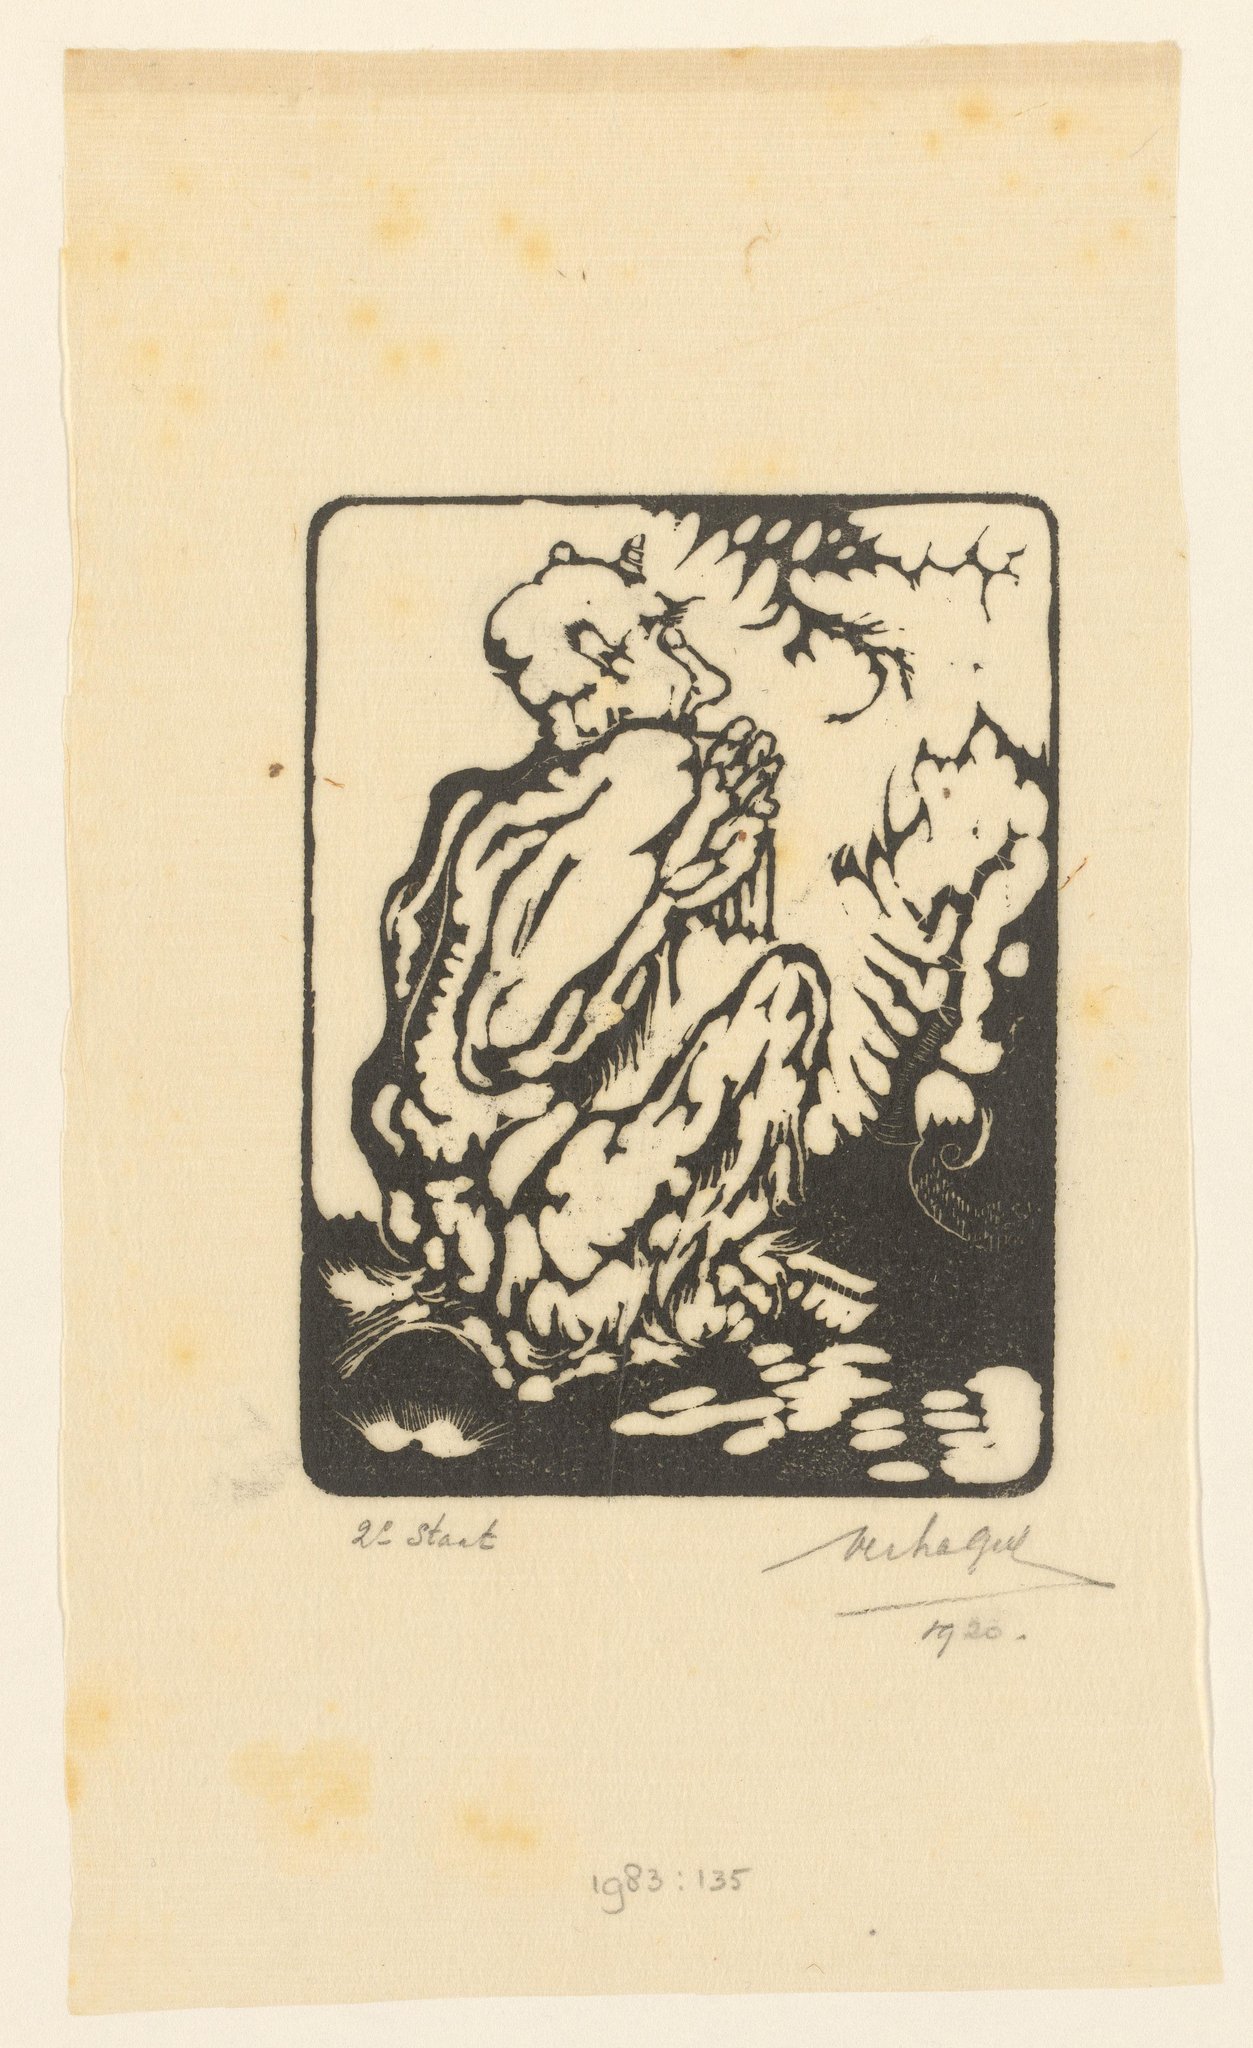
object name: print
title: Faun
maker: otto verhagen (i)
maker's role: draughtsman, print maker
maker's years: 1885-1951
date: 1920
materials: paper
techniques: woodcut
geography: netherlands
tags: satyrs, fauns, sileni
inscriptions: date